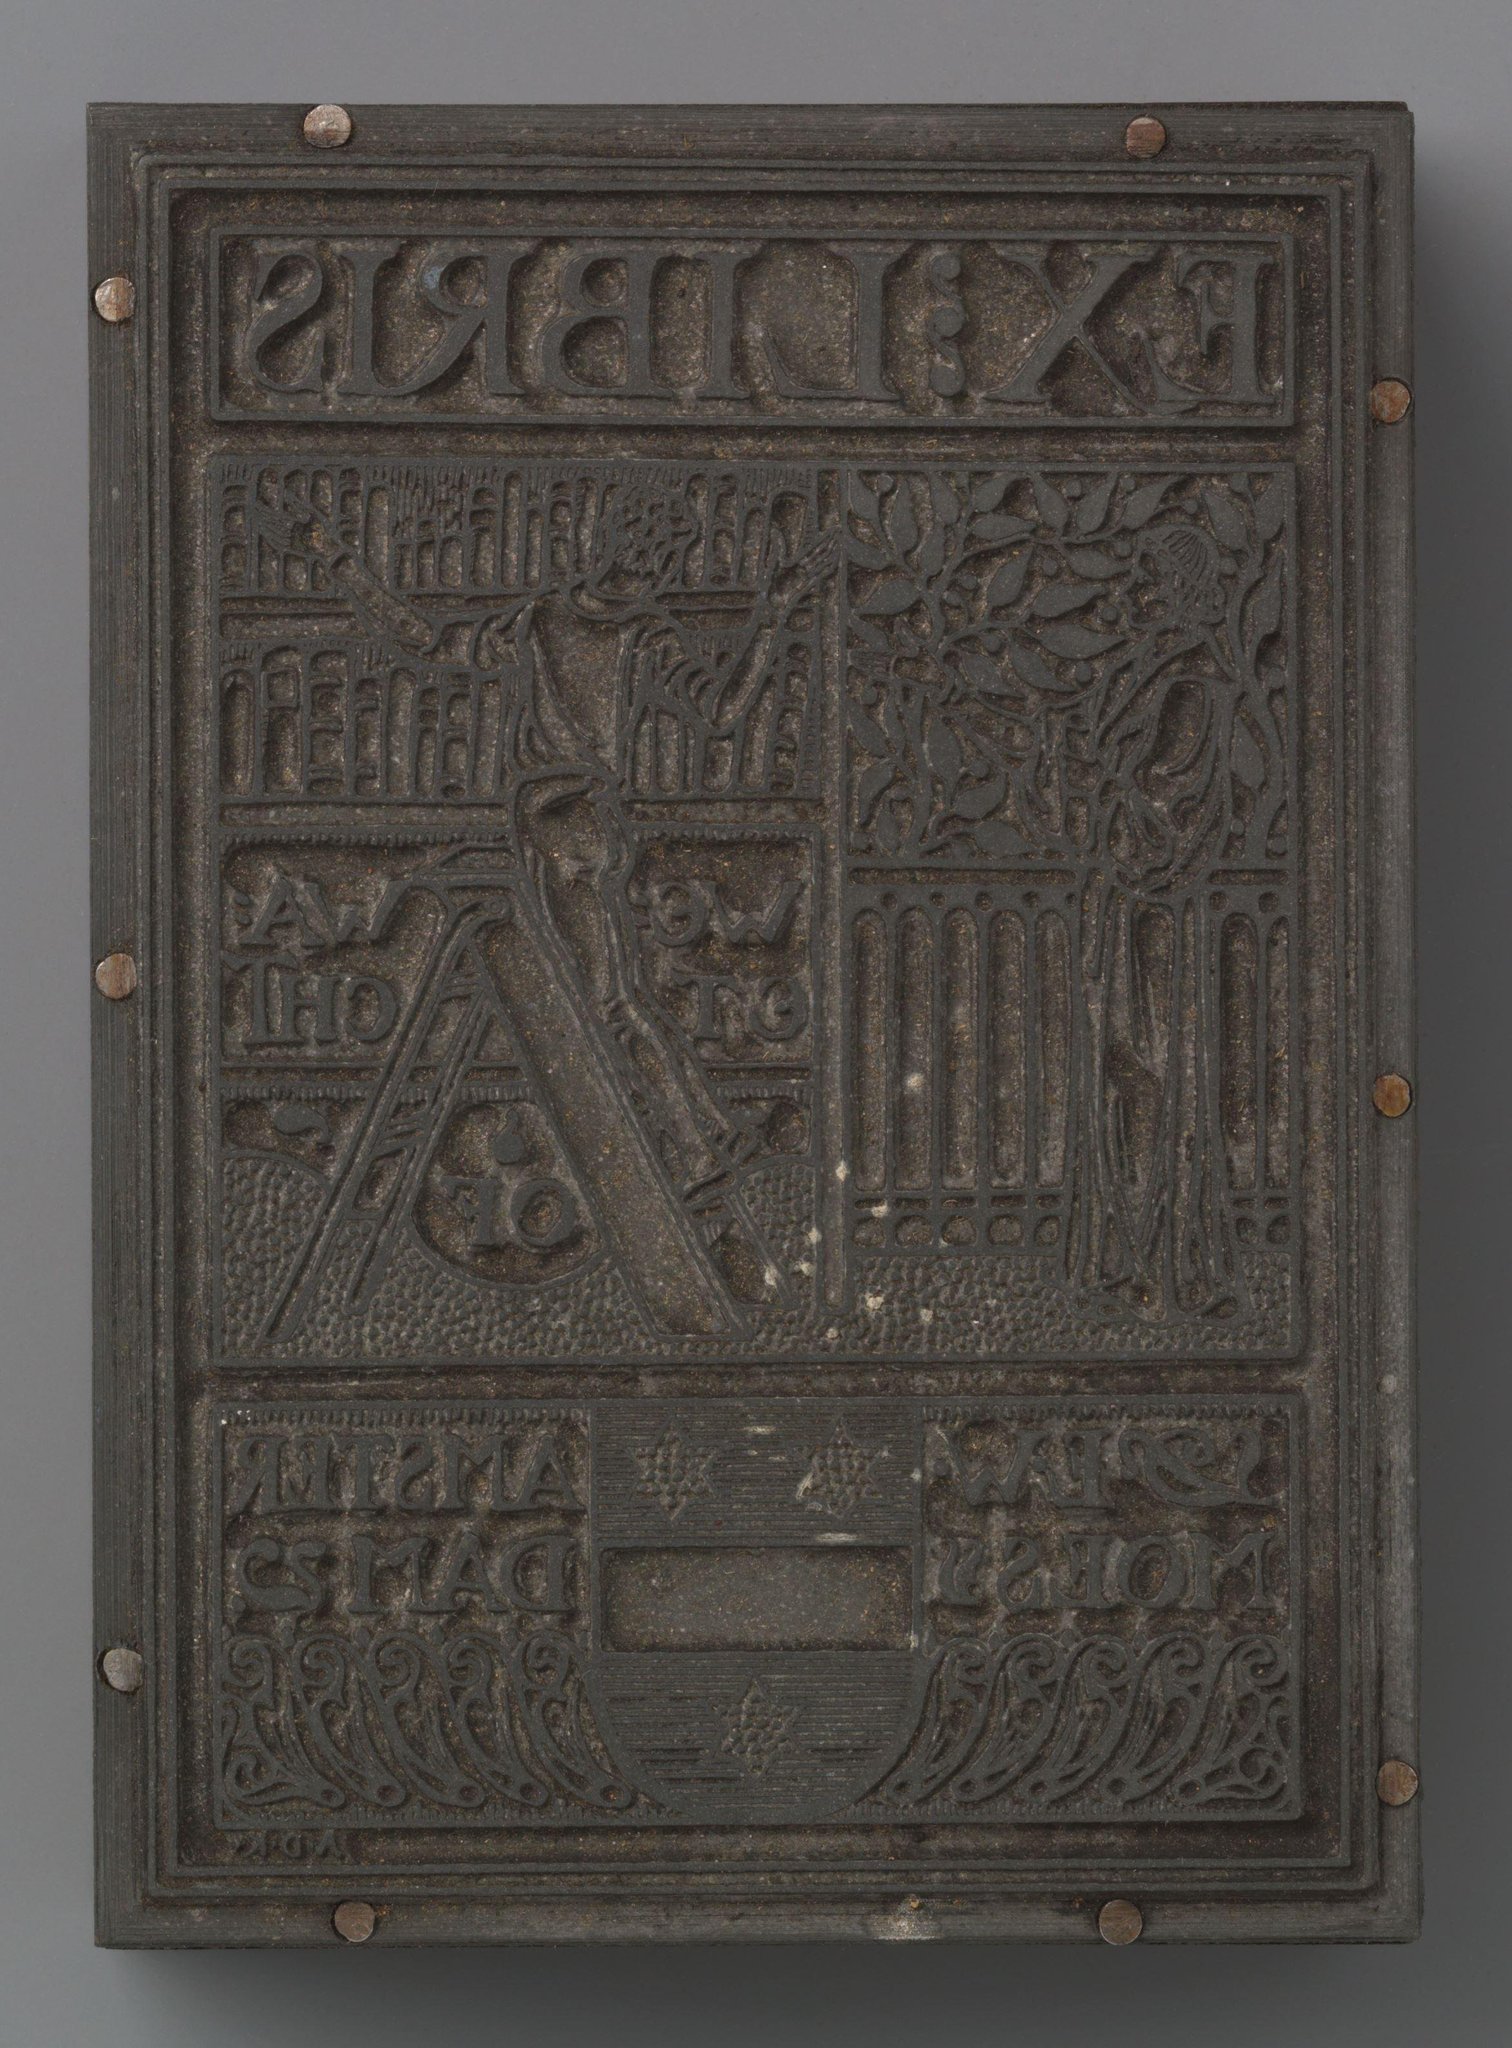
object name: zinkplaat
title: Ex libris van E.W. Moes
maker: antoon derkinderen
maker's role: draughtsman, painter, print maker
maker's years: 1859-1925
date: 1893-1902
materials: zinc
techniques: printing block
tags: ernst wilhelm moes